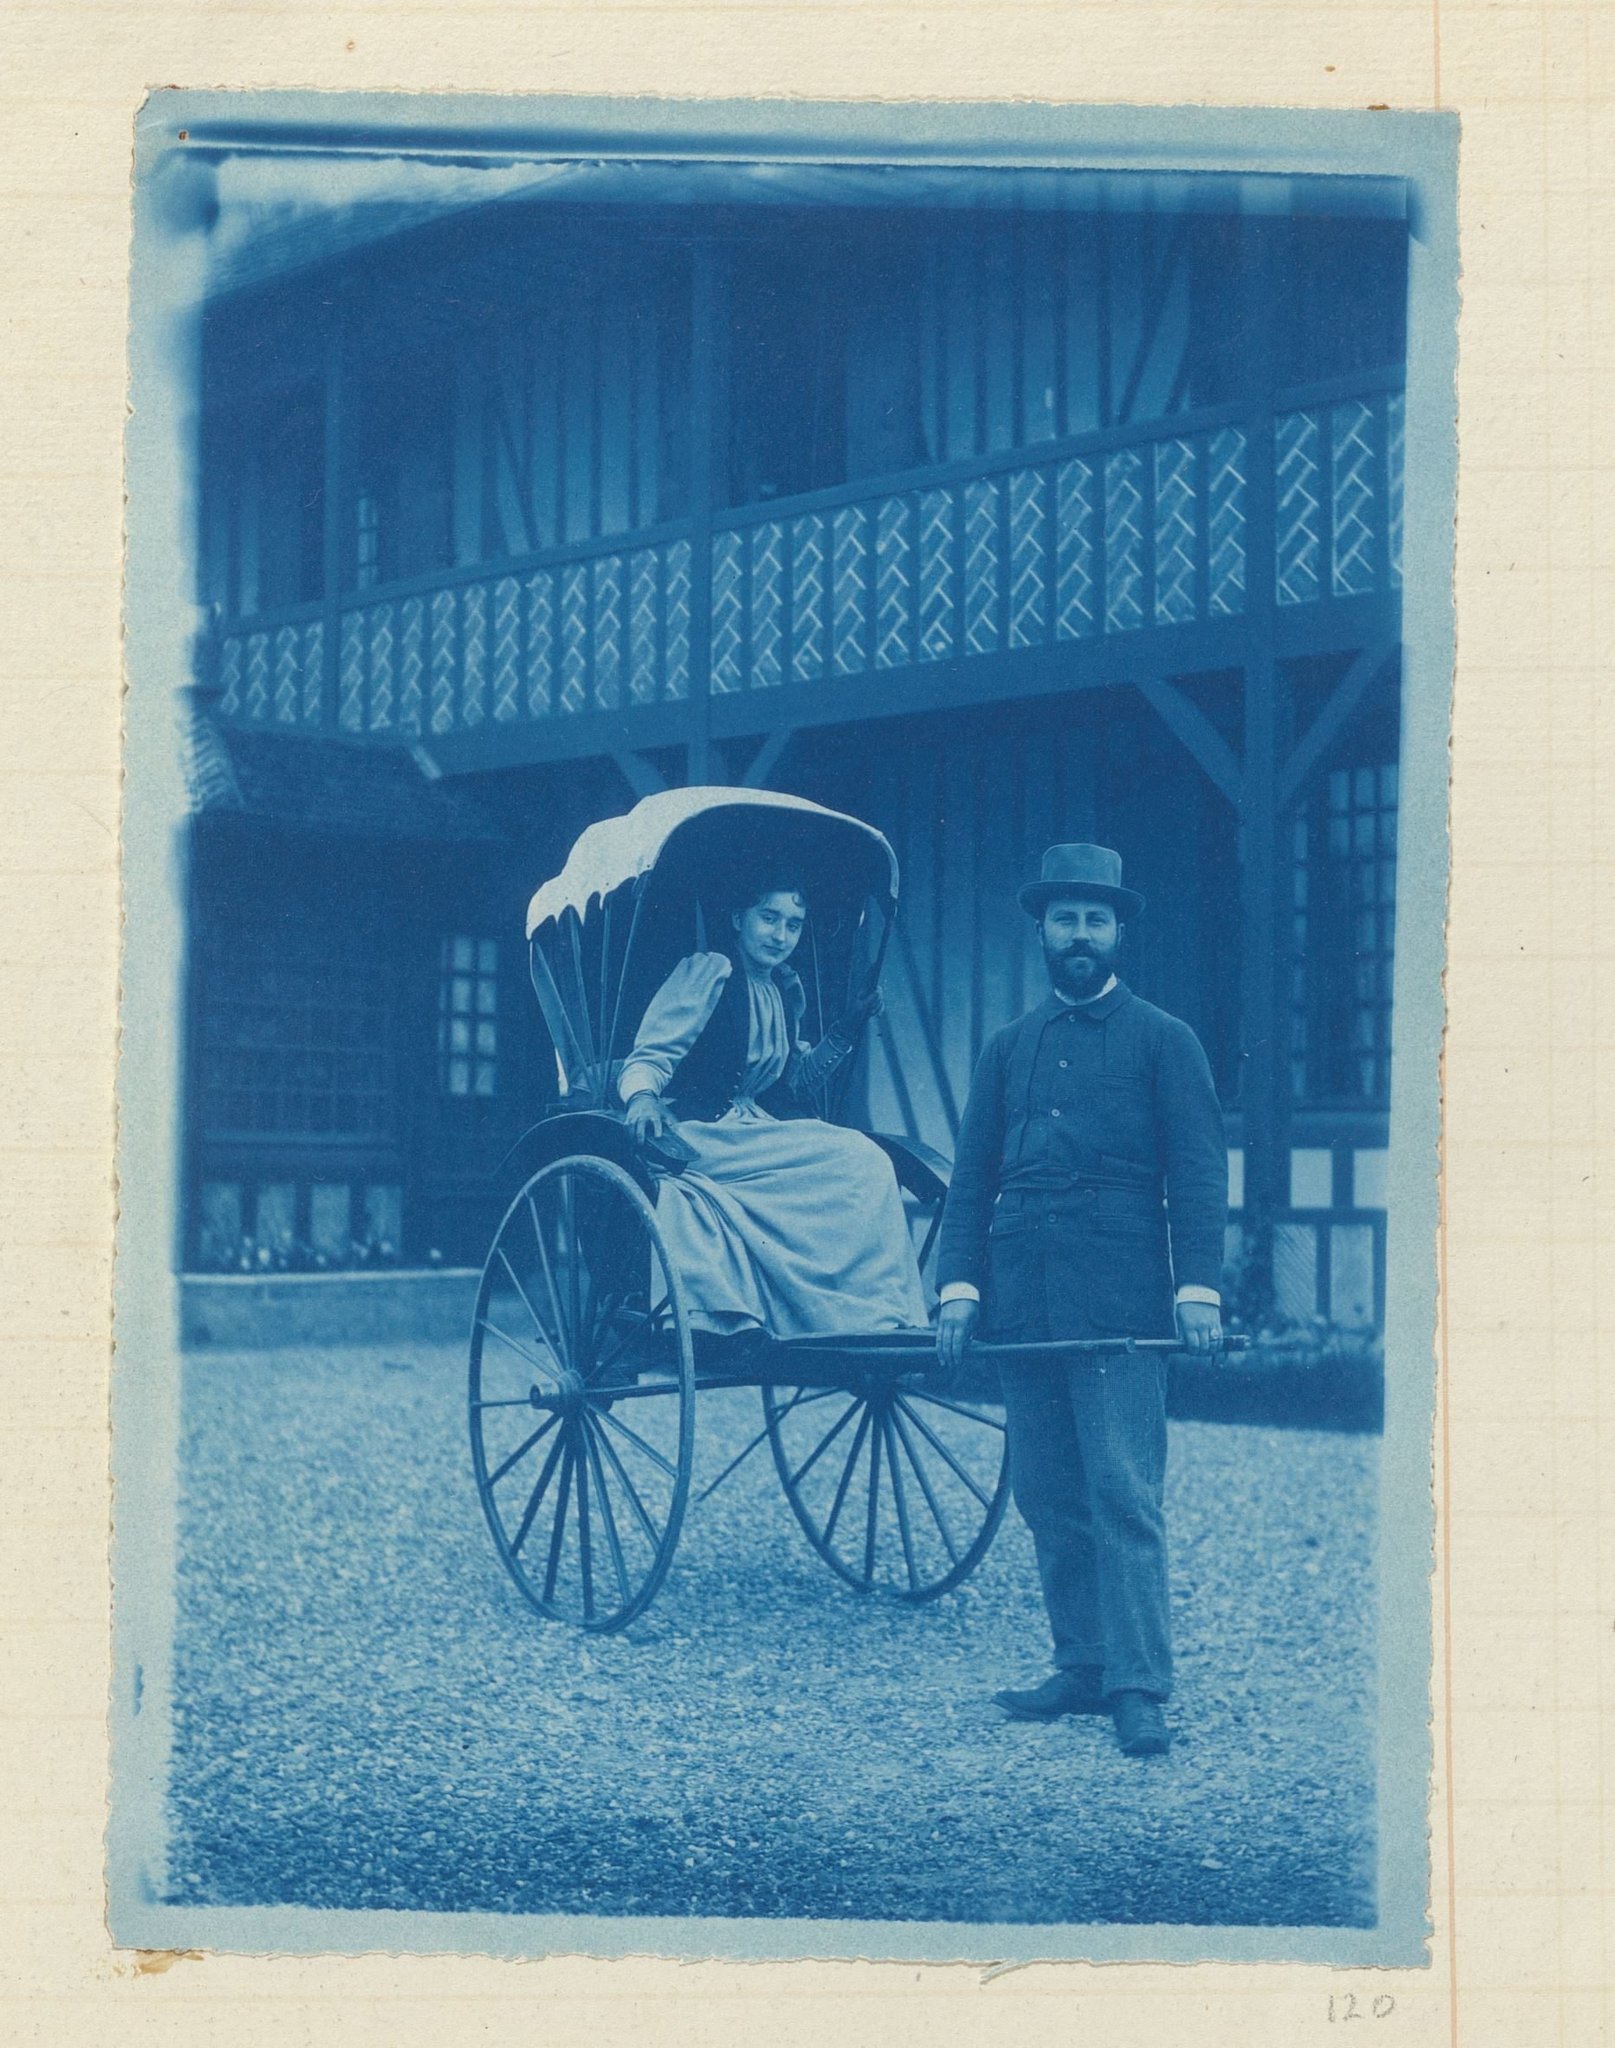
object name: photograph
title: Portret van een man en een vrouw, zij zittend in een rijtuig, hij erbij staand met de dissel in de handen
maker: Anonymous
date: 1880-1900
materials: paper, photographic support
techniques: cyanotype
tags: adult woman, two-wheeled, animal-drawn vehicle, adult man